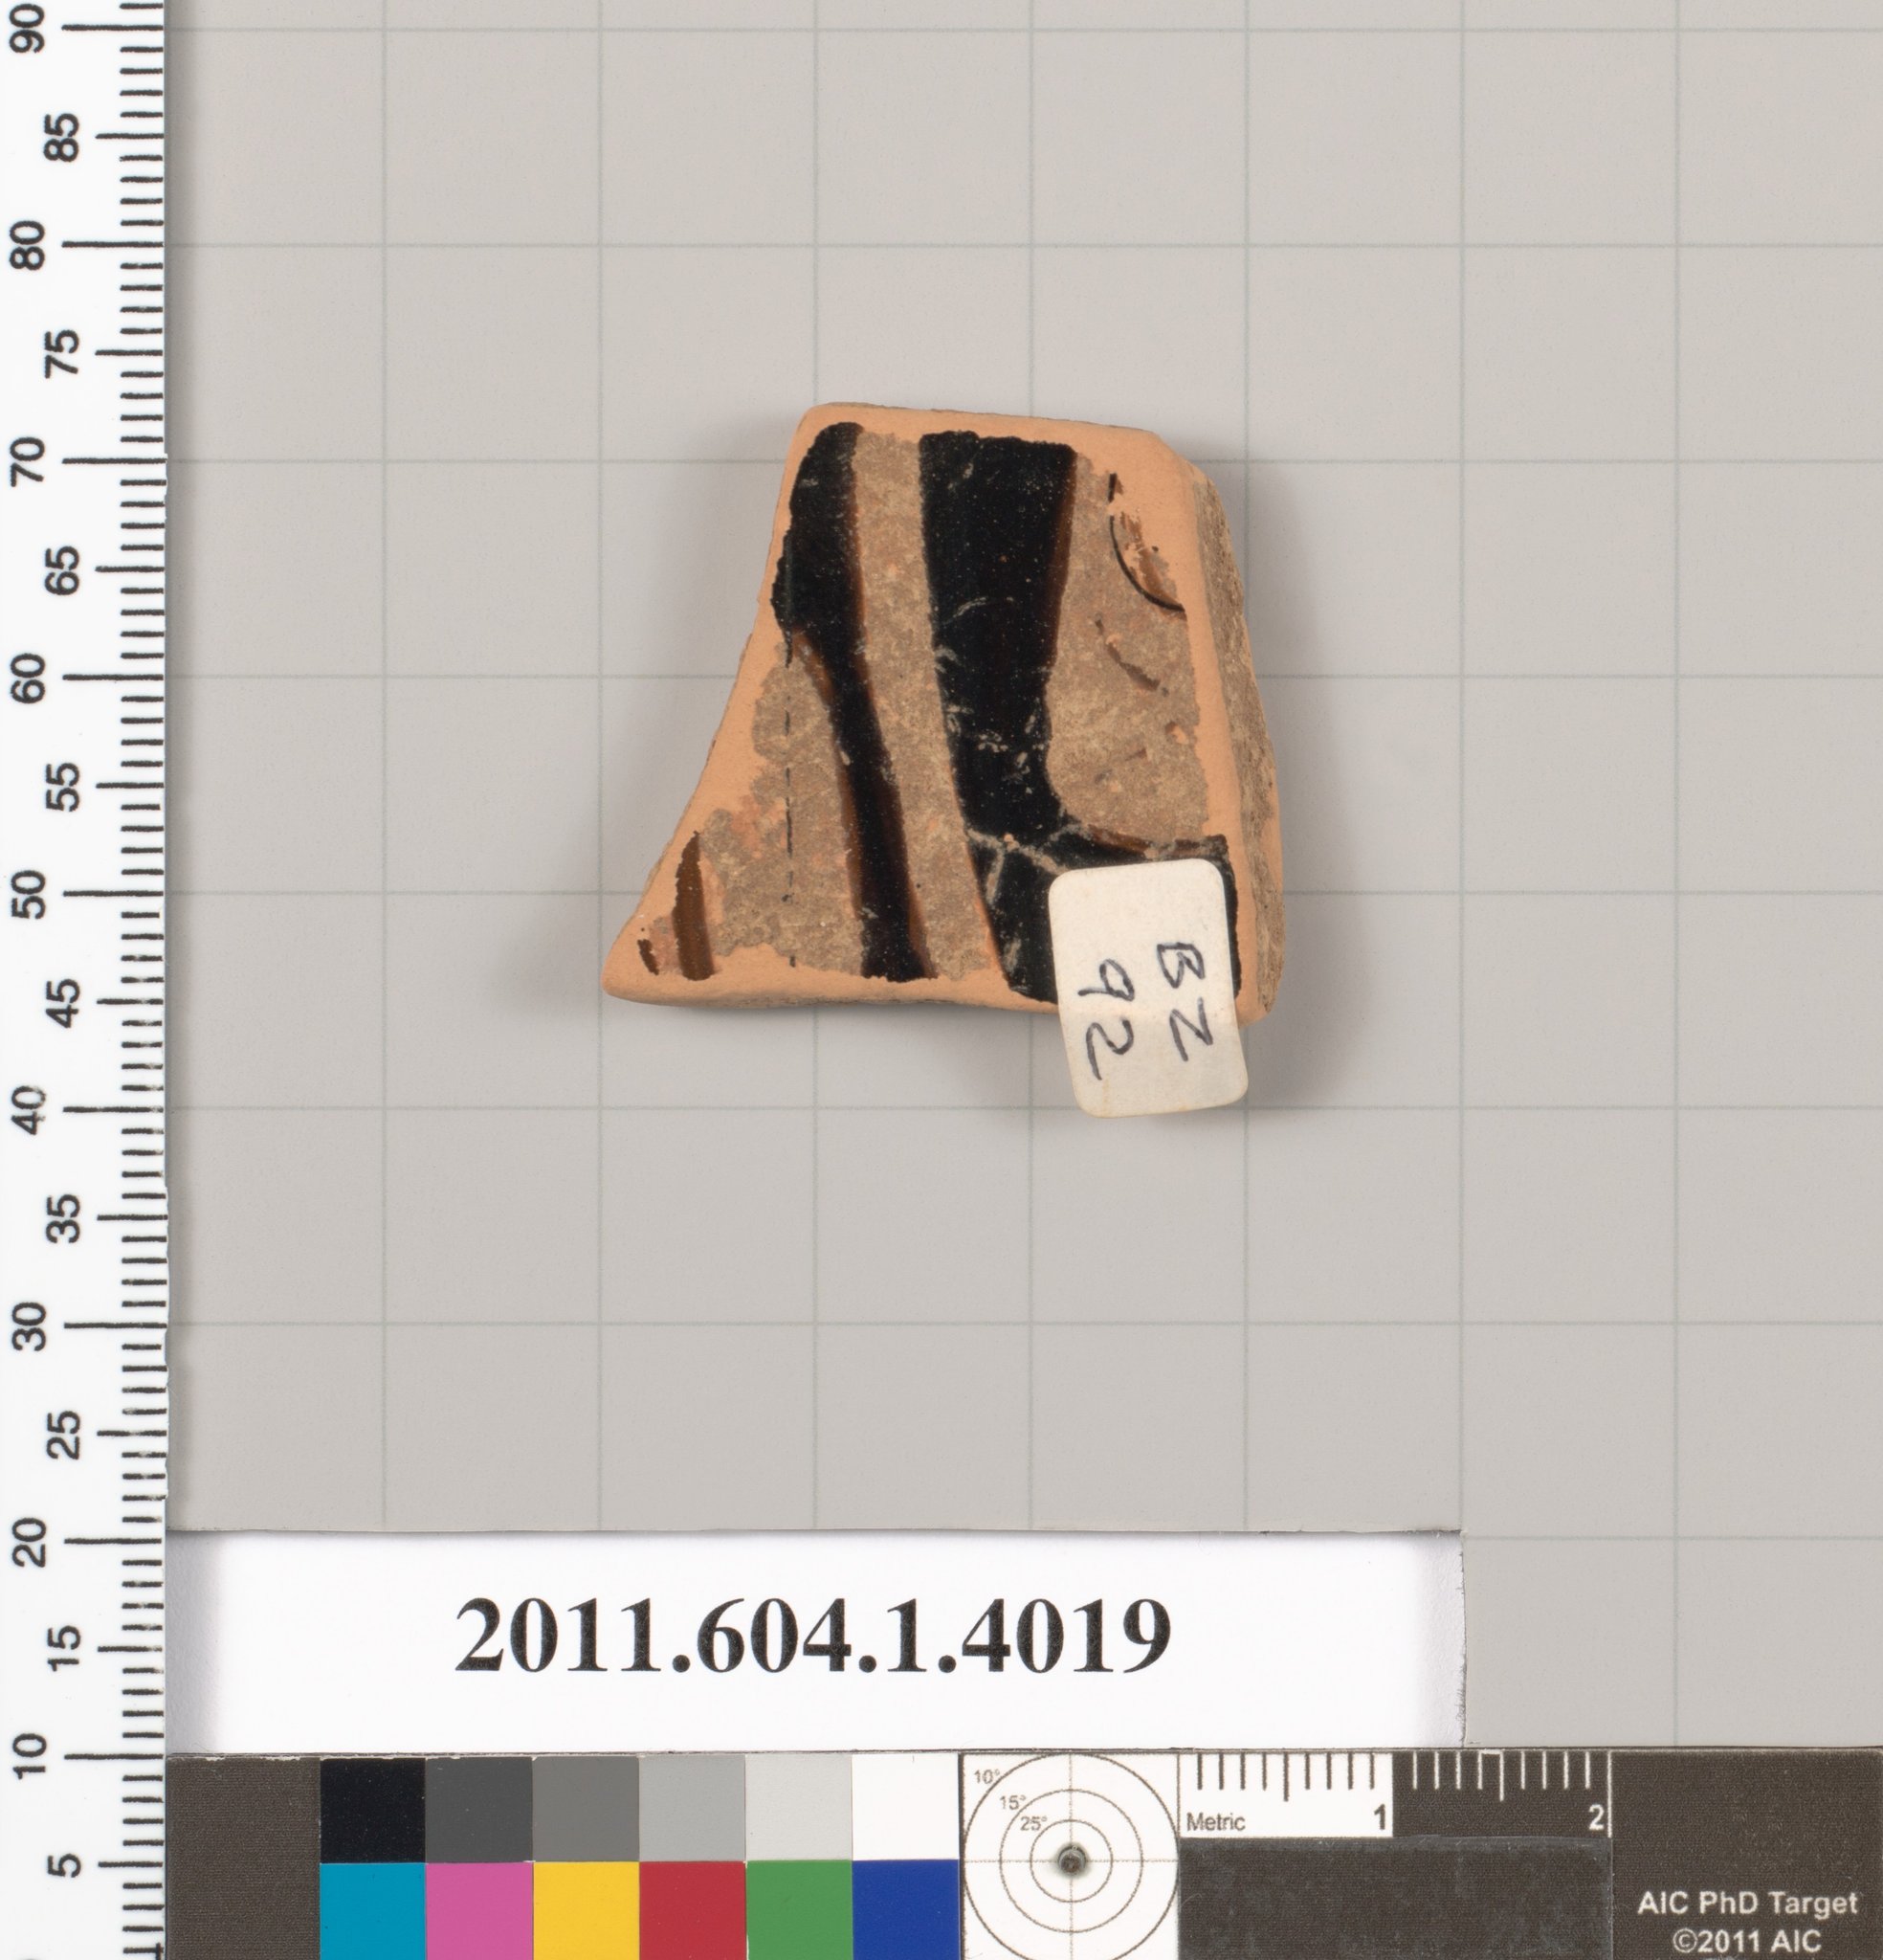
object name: kylix fragment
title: Terracotta fragment of a kylix (drinking cup)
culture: greek, attic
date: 460-440 BCE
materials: terracotta